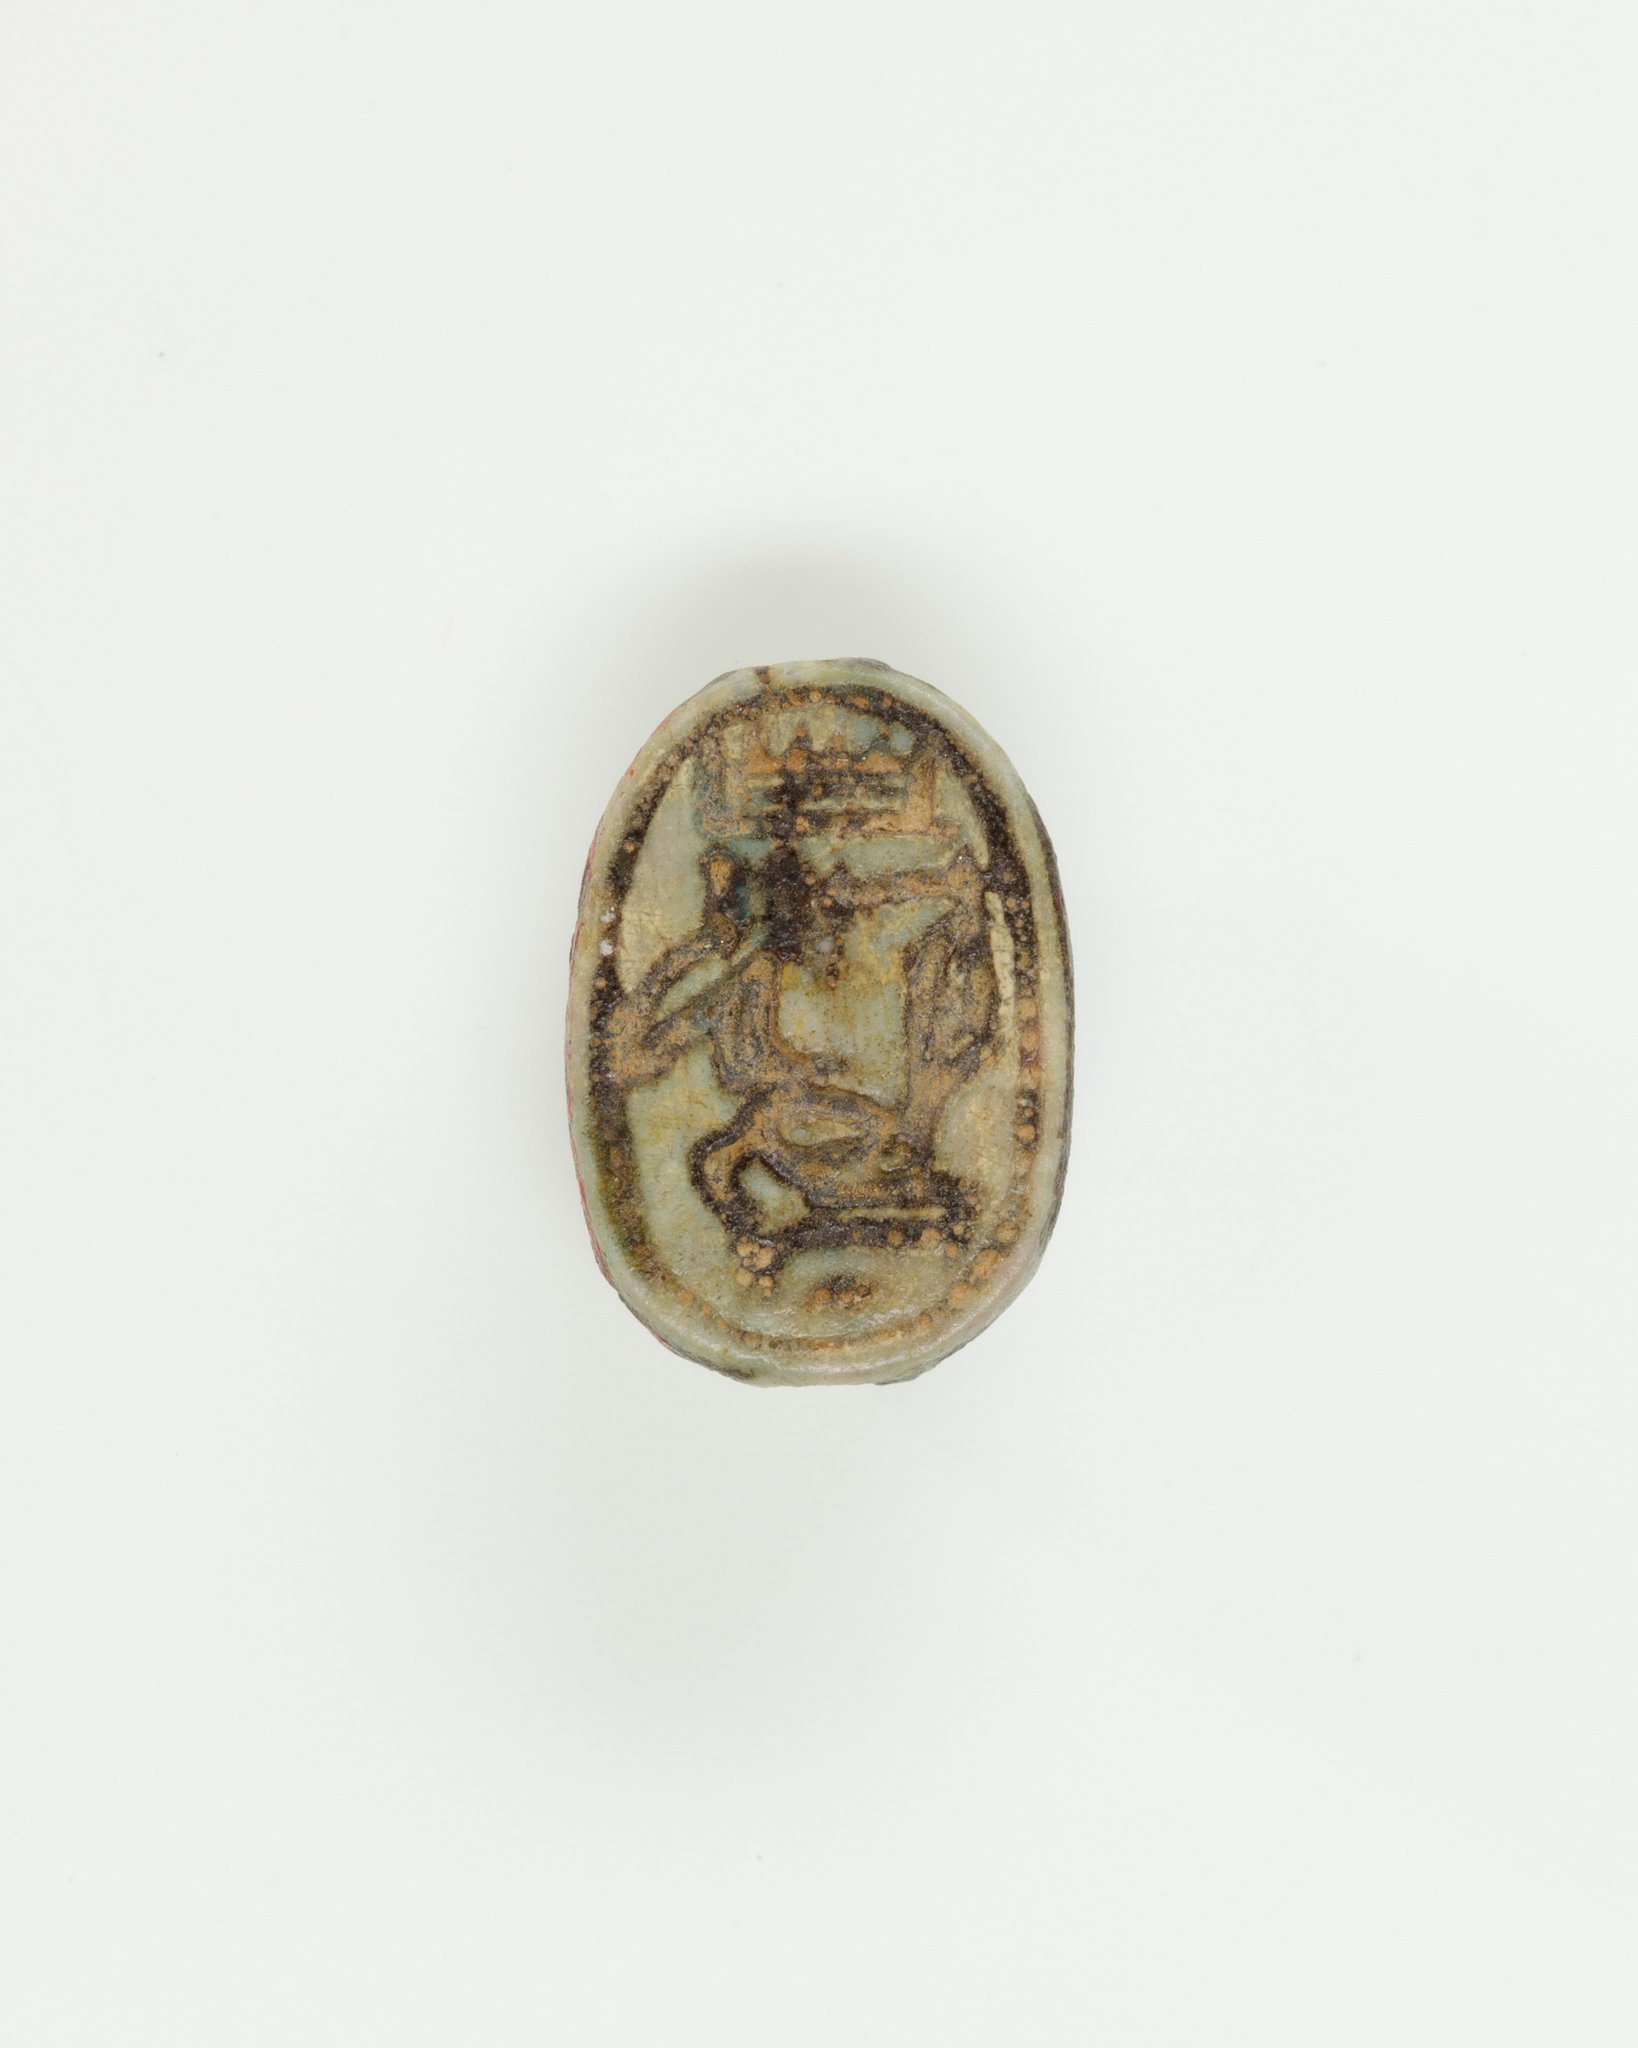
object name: scarab, amenemhat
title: Scarab of Amenemhat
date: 1981-1802 BCE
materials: stone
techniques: glazing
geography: egypt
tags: scarabs